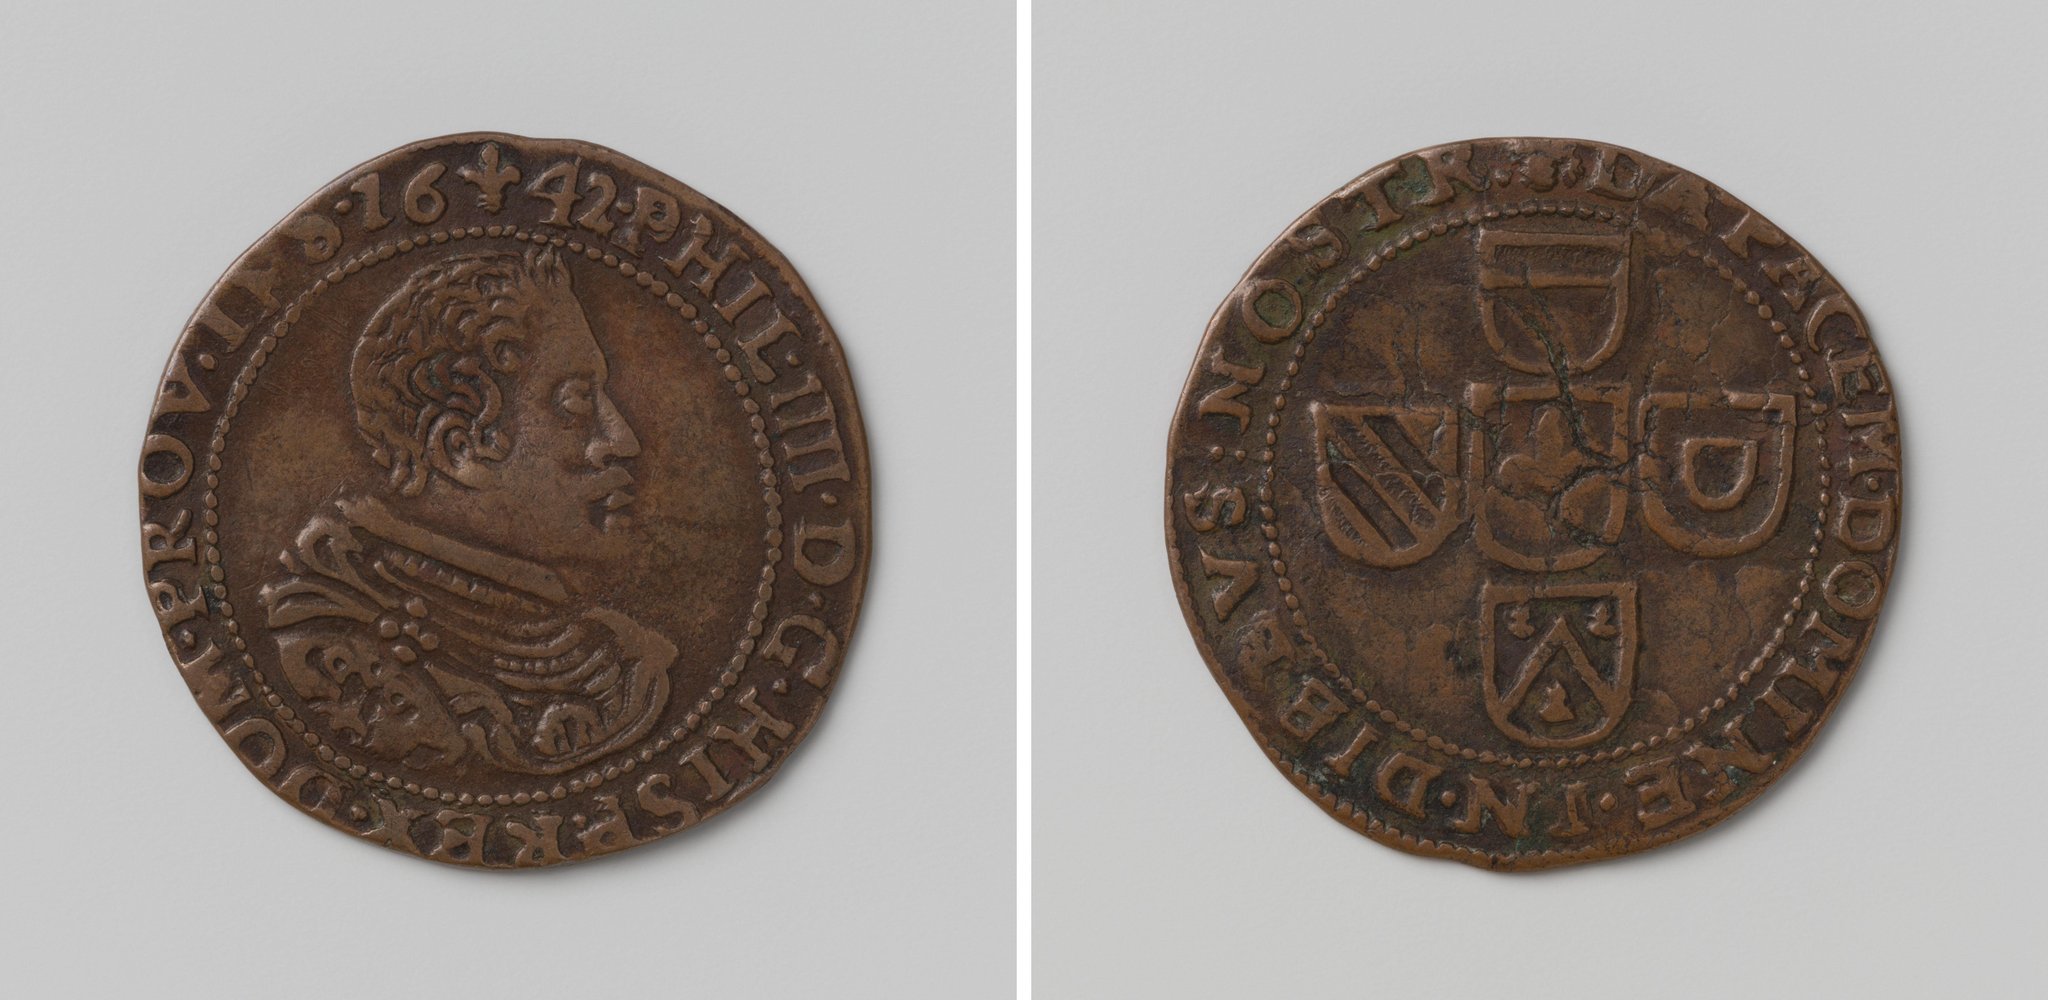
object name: jeton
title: Hoop op vrede, rekenpenning geslagen ter ere van Filips IV, koning van Spanje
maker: Anonymous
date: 1642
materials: copper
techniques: striking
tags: filips iv (koning van spanje), lille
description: Koperen penning. Voorzijde: borststuk man binnen omschrift. Keerzijde: wapenschild, omgeven door vier wapenschilden binnen omschrift.